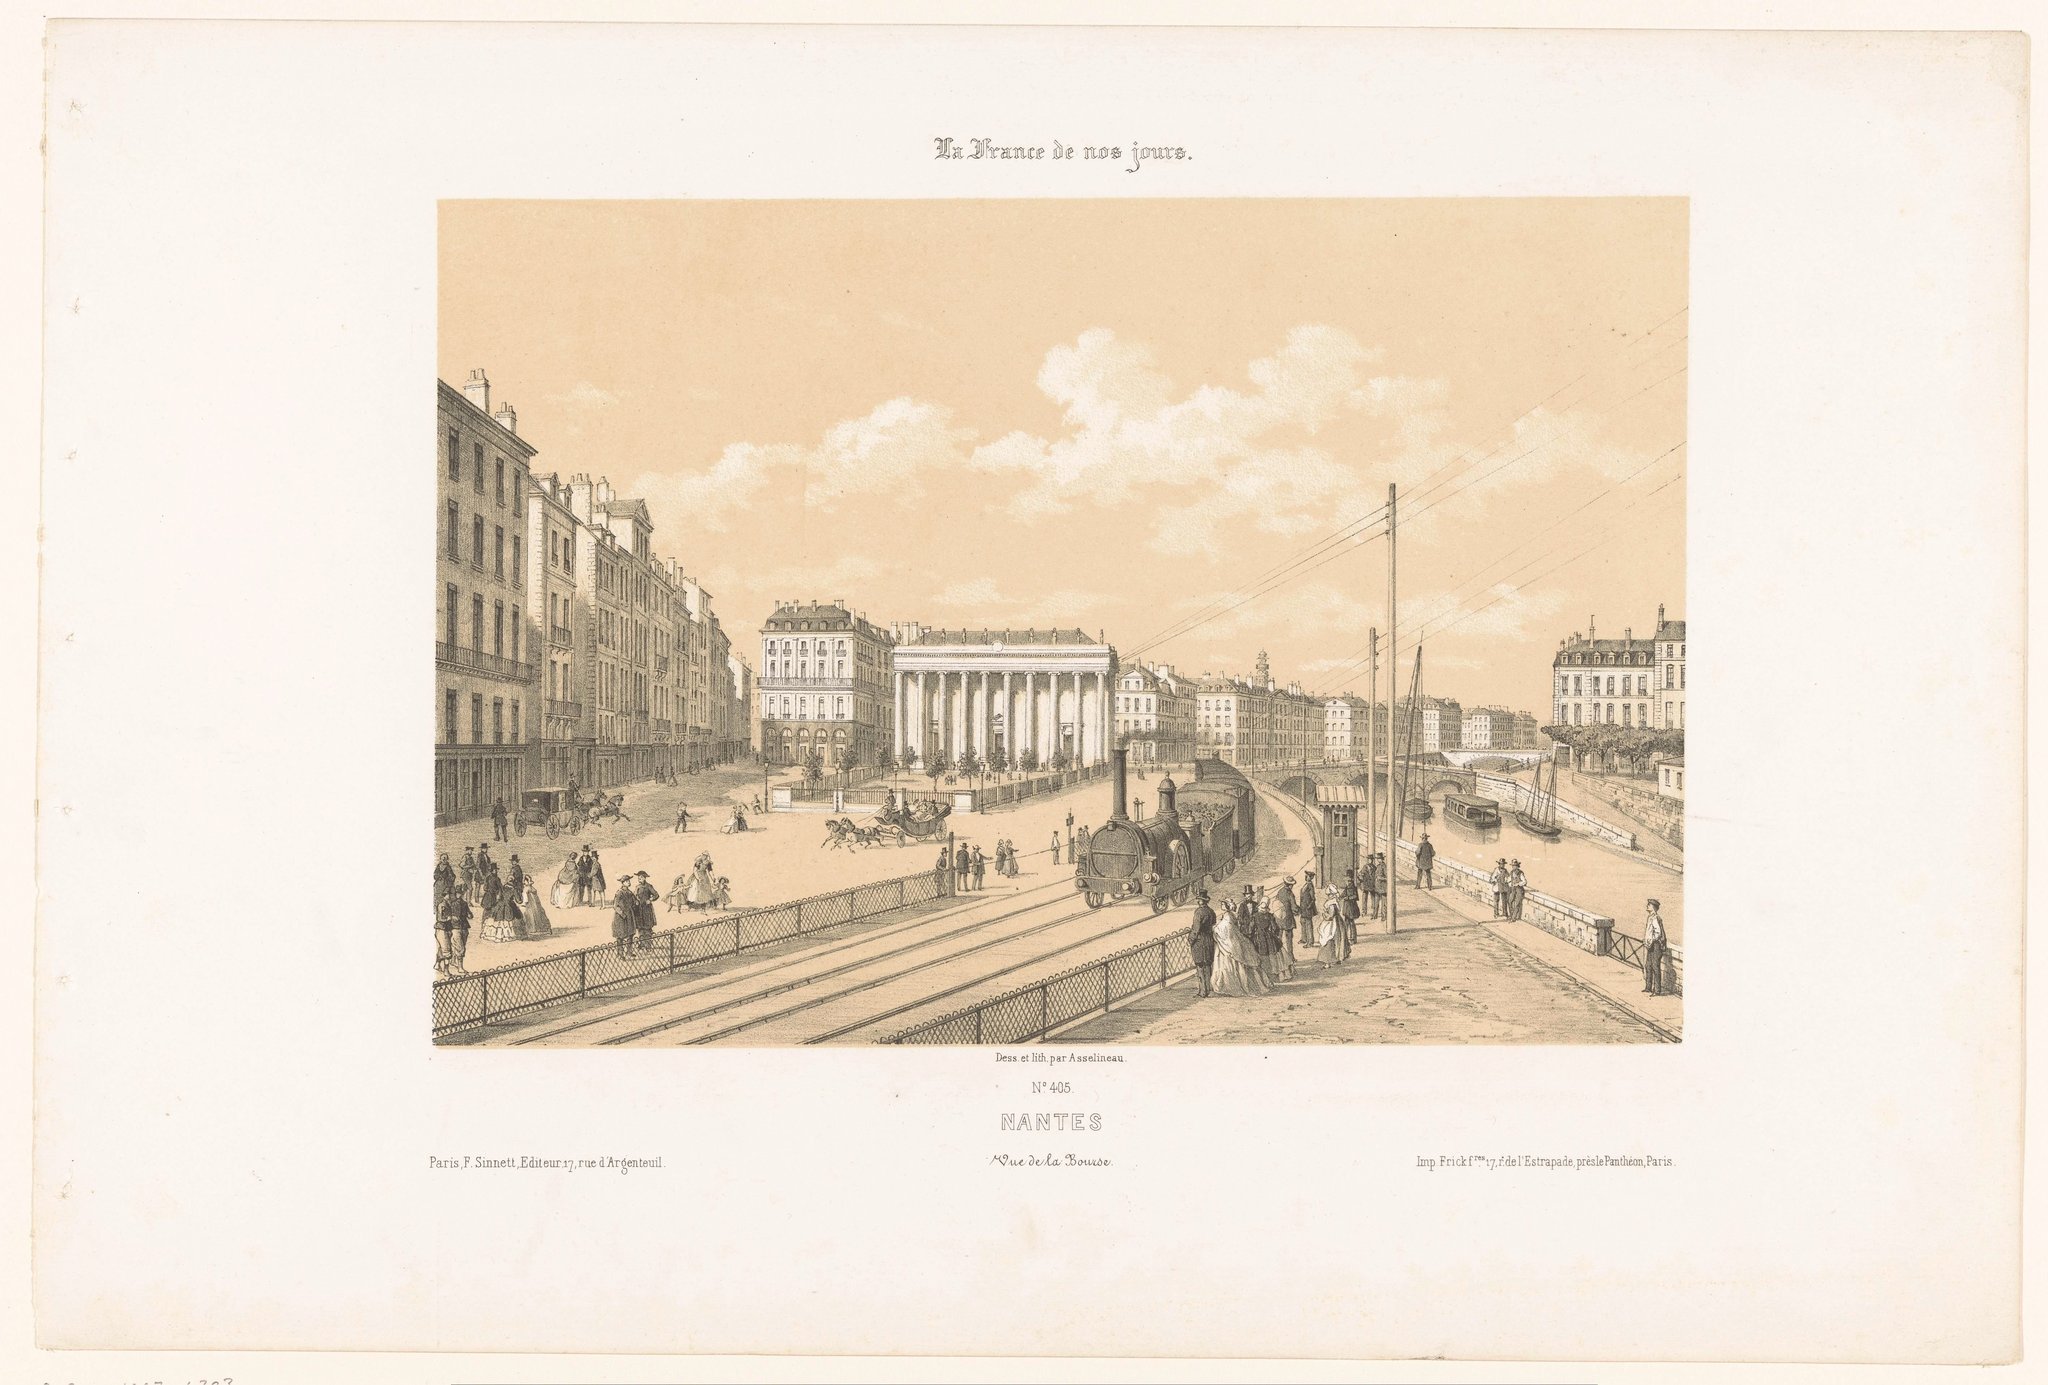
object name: print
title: Nantes. Vue de la Bourse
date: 1863-1864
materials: paper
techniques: tone lithography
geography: paris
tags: canals, waters (in village), steam locomotive, edifice, e.g.: public building, department store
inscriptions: collector's mark: Lugt 2228